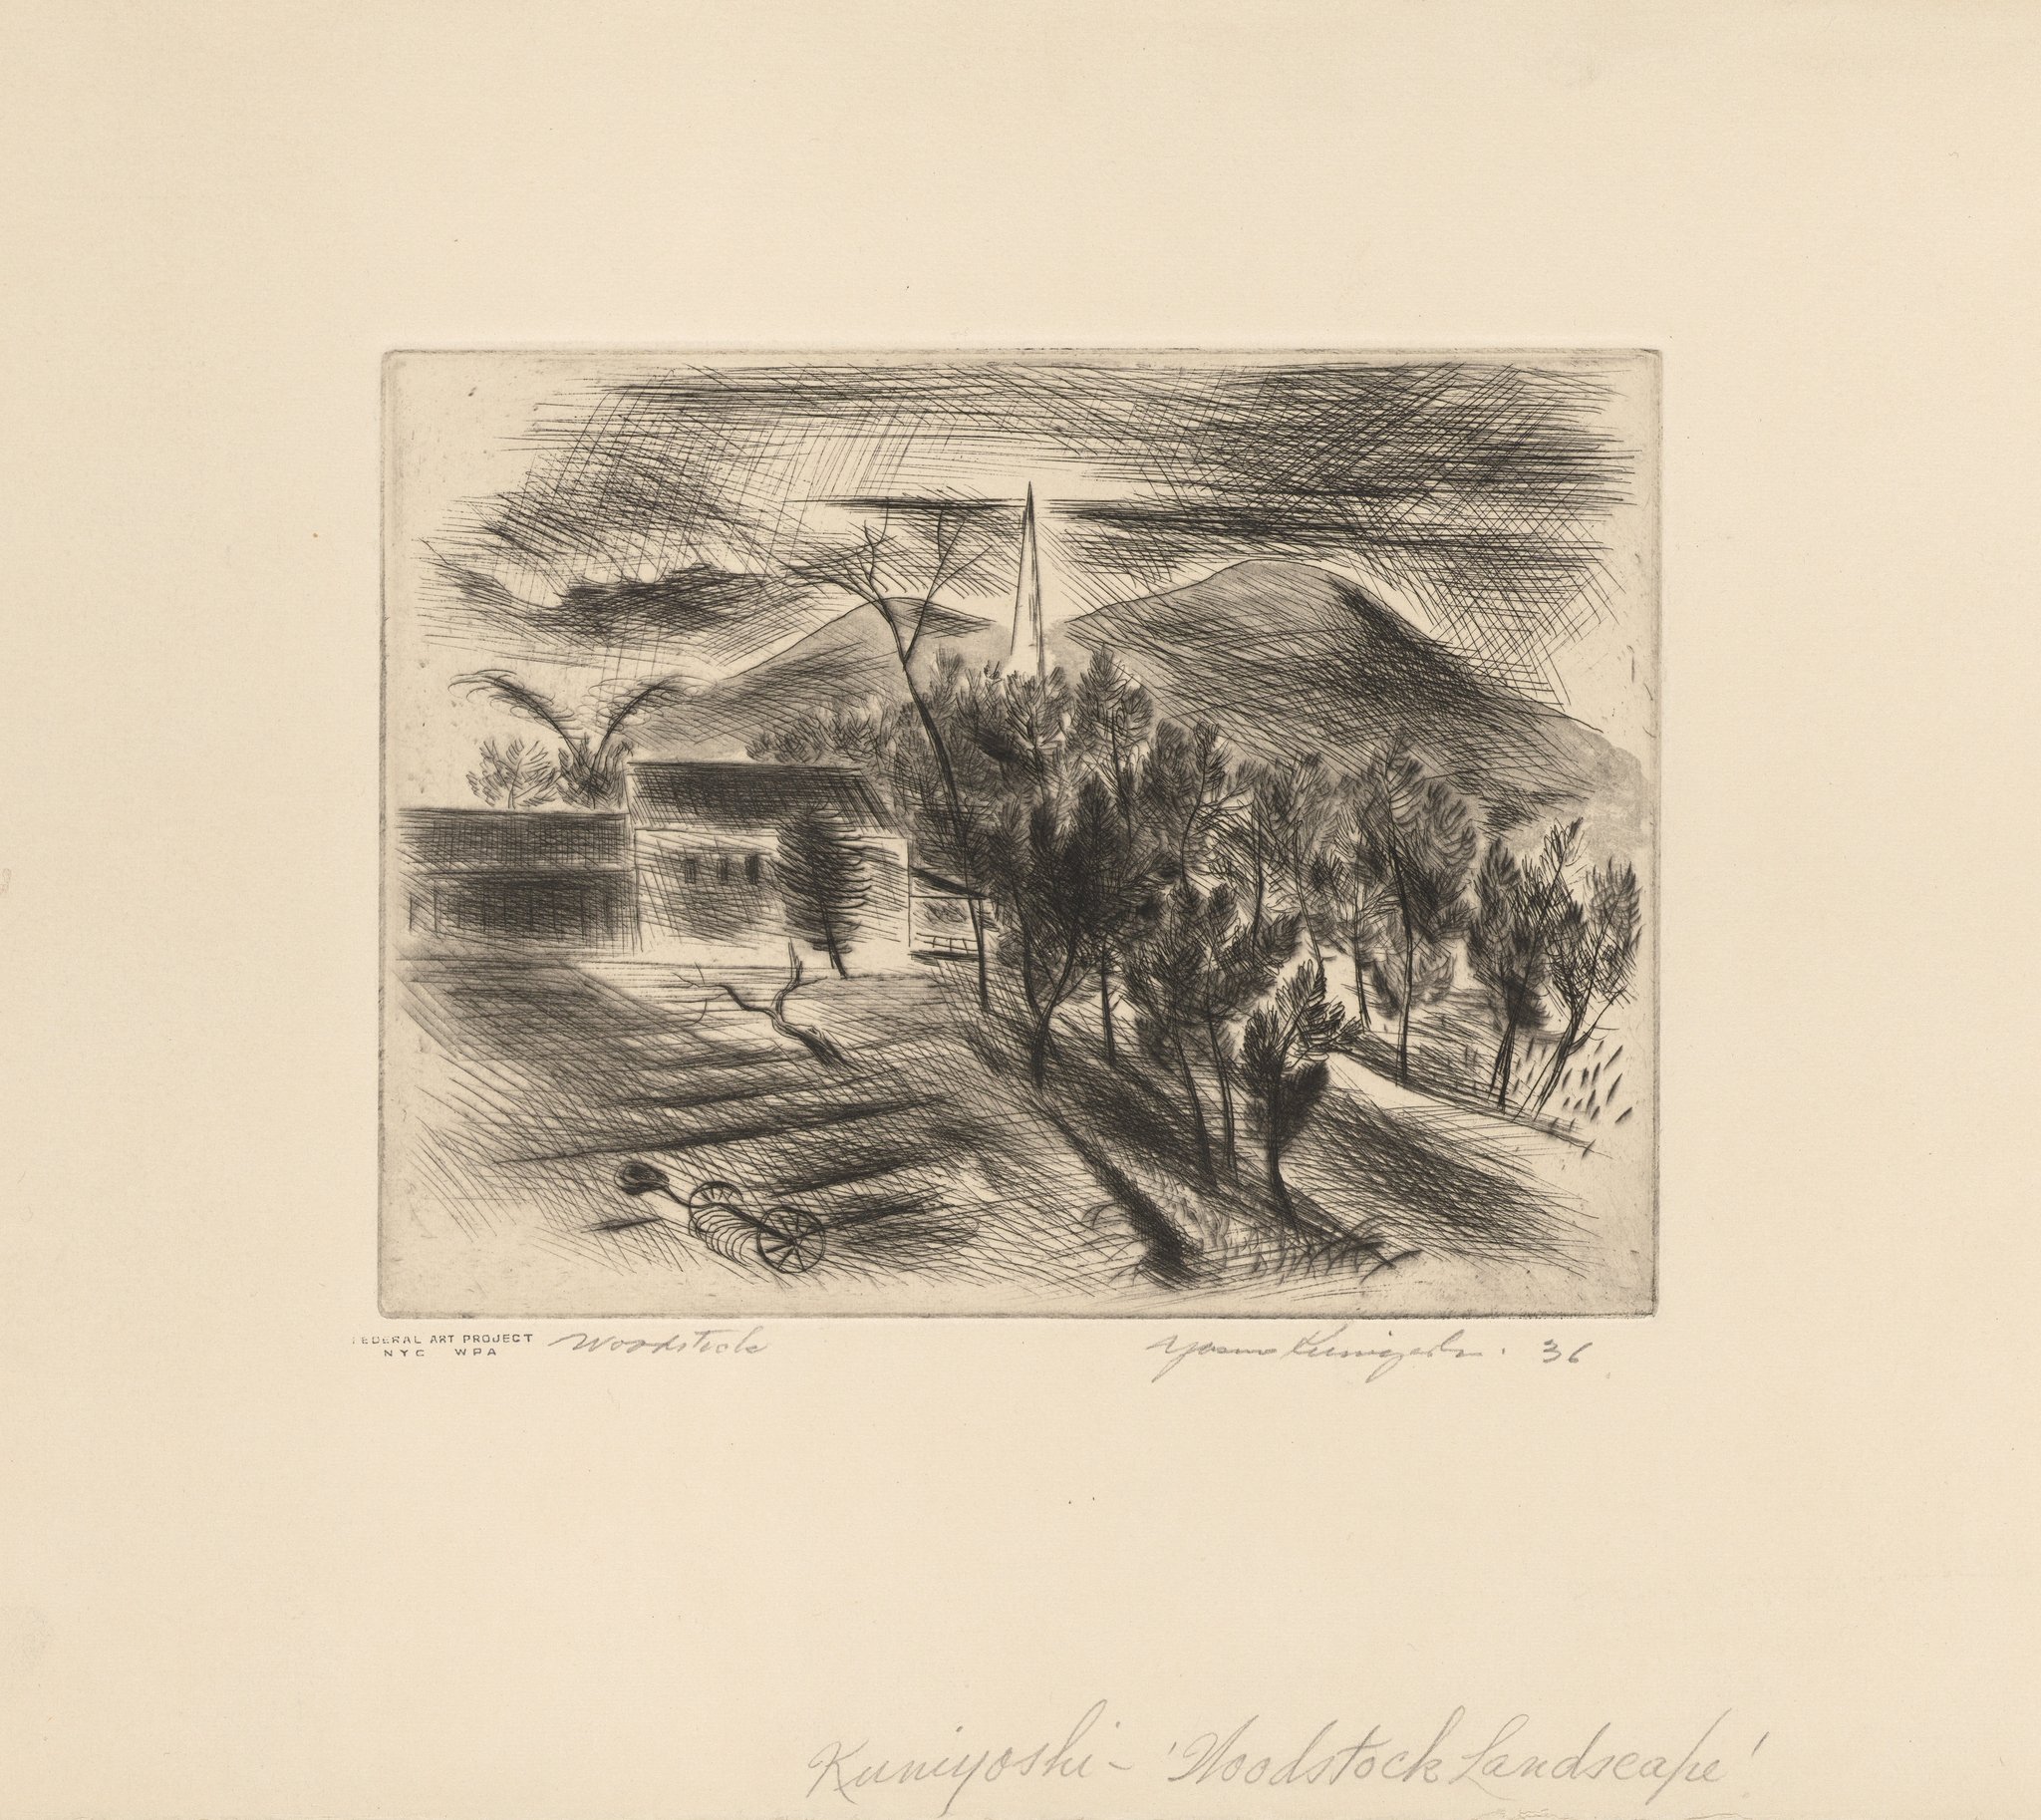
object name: print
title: Woodstock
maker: yasuo kuniyoshi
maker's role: artist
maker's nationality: american, born japan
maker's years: 1889-1953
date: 1936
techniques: etching